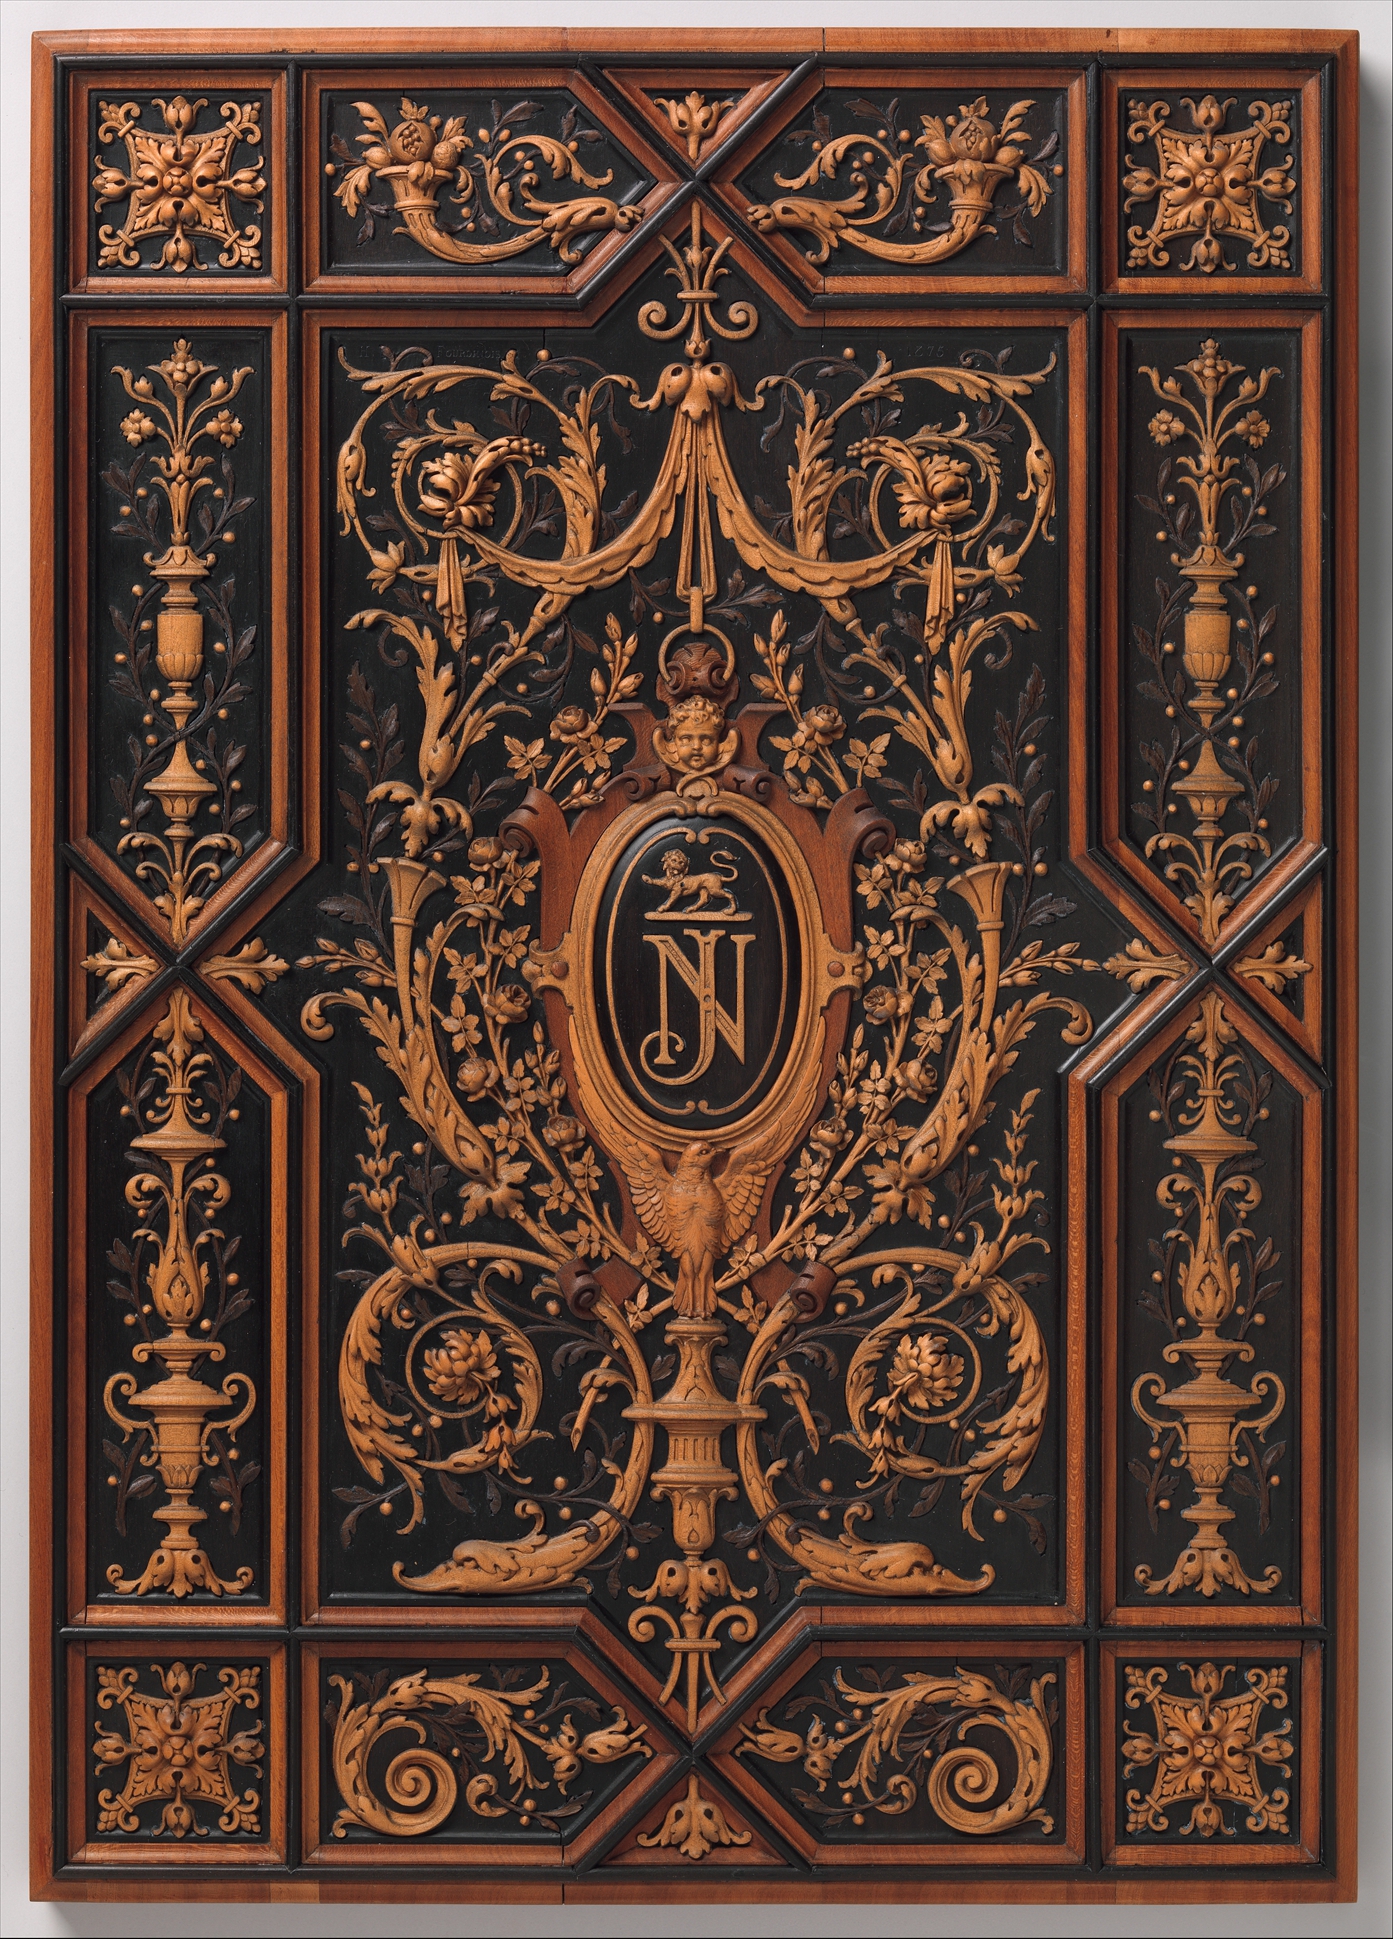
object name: book or album cover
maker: henry-auguste fourdinois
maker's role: maker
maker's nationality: french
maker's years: 1830-1907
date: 1875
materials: wood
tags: coat of arms